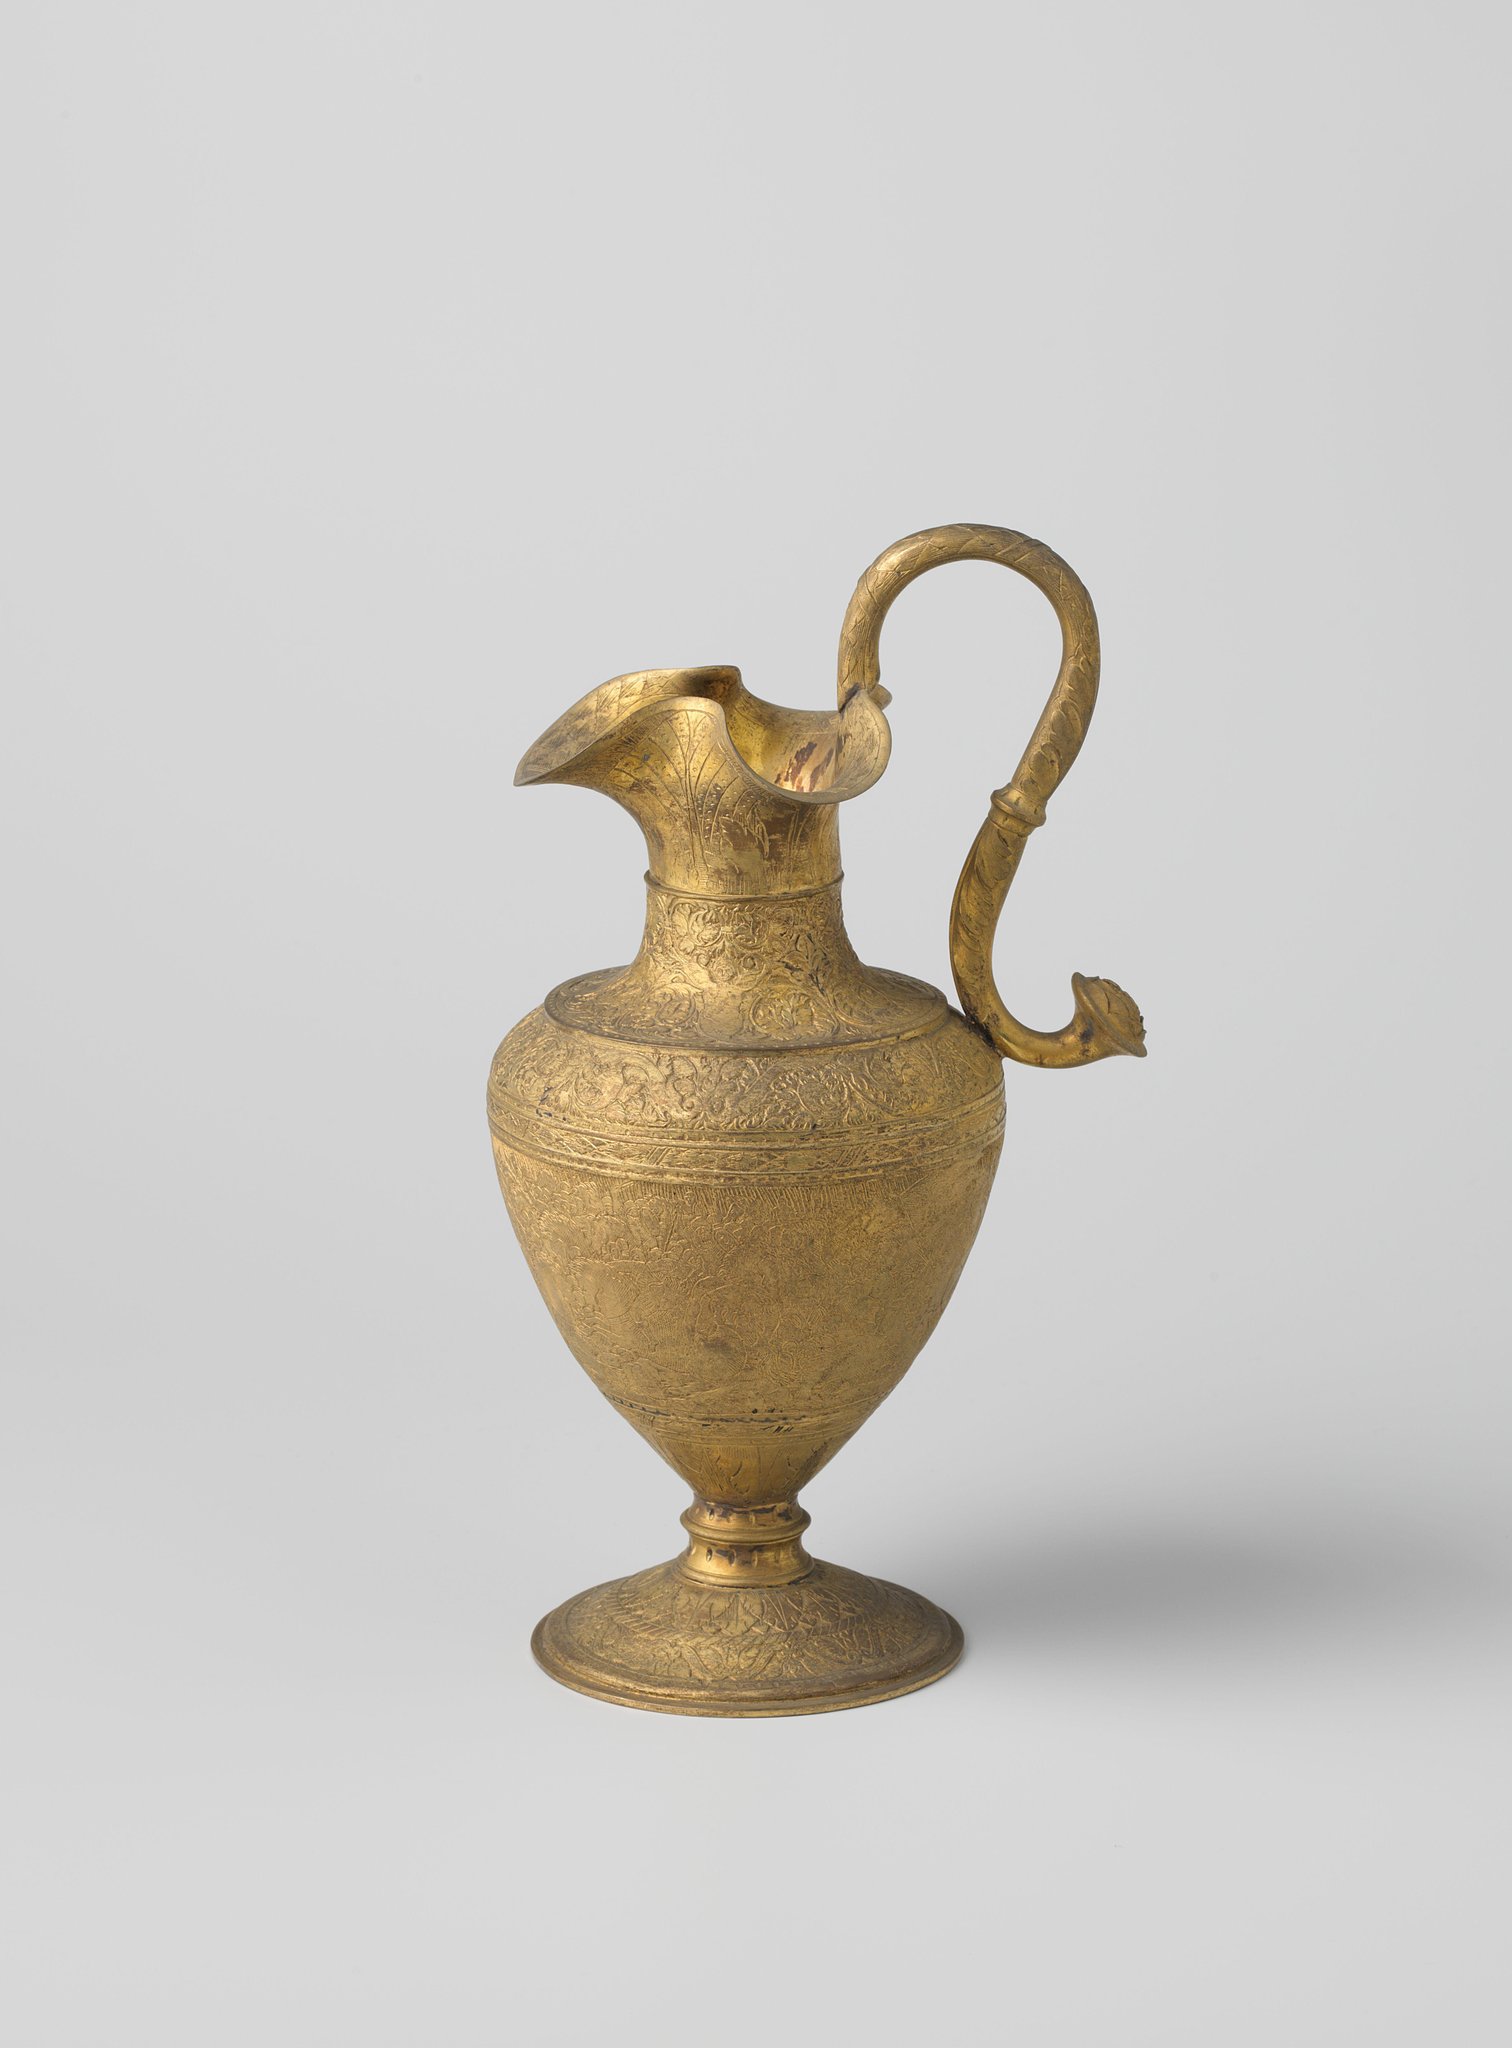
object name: ewer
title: Galvanoplastische reproductie van een kan met voorstelling van een klassieke strijdscène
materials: copper, silver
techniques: gilding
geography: london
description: Galvanoplastische reproductie van een kan met gedreven voorstelling van een klassieke strijdscène.